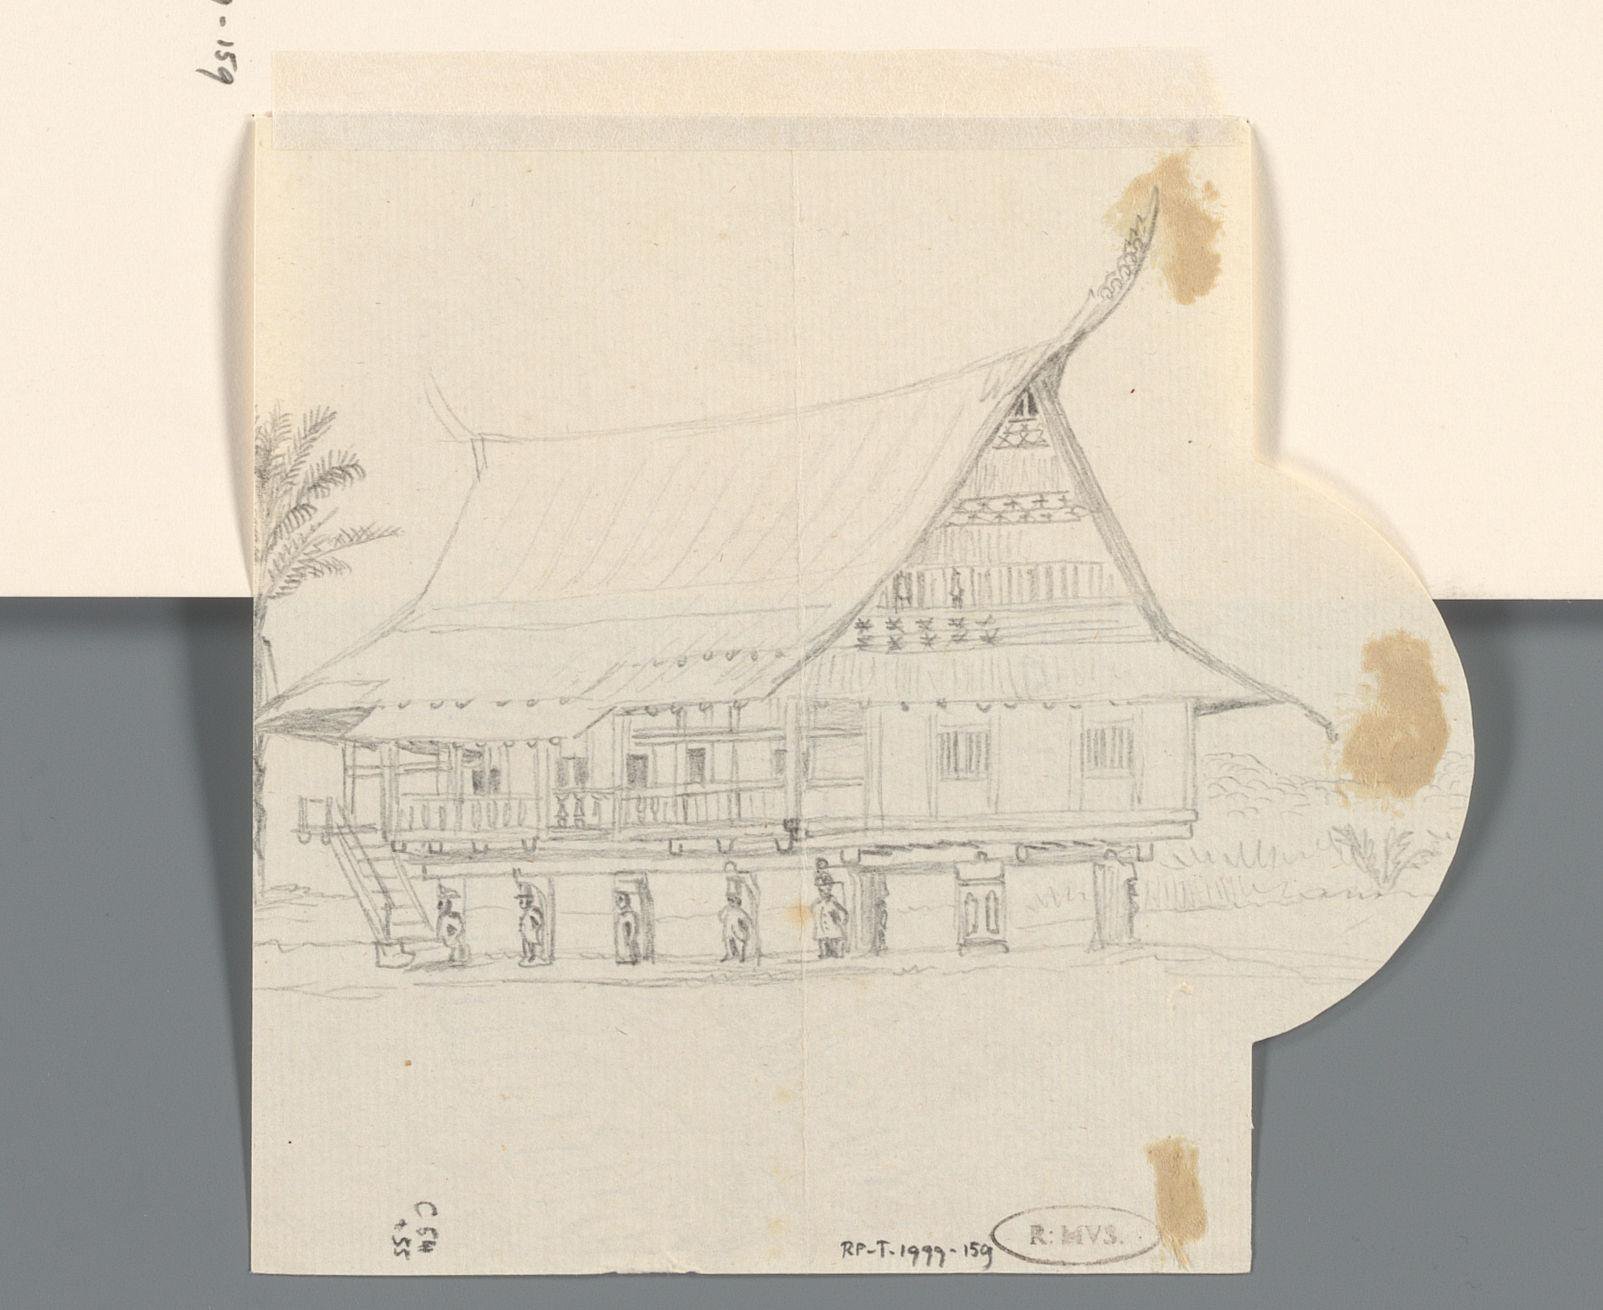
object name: drawing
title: Huis op palen van Tondano, Noord-Celebes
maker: adrianus johannes bik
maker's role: draughtsman, print maker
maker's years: 1790-1872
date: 1821-1824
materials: paper, pencil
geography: north celebes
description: Huis op palen, versierd met gebeeldhouwde beelden van Europeanen, van Tondano; Noord-Celebes.